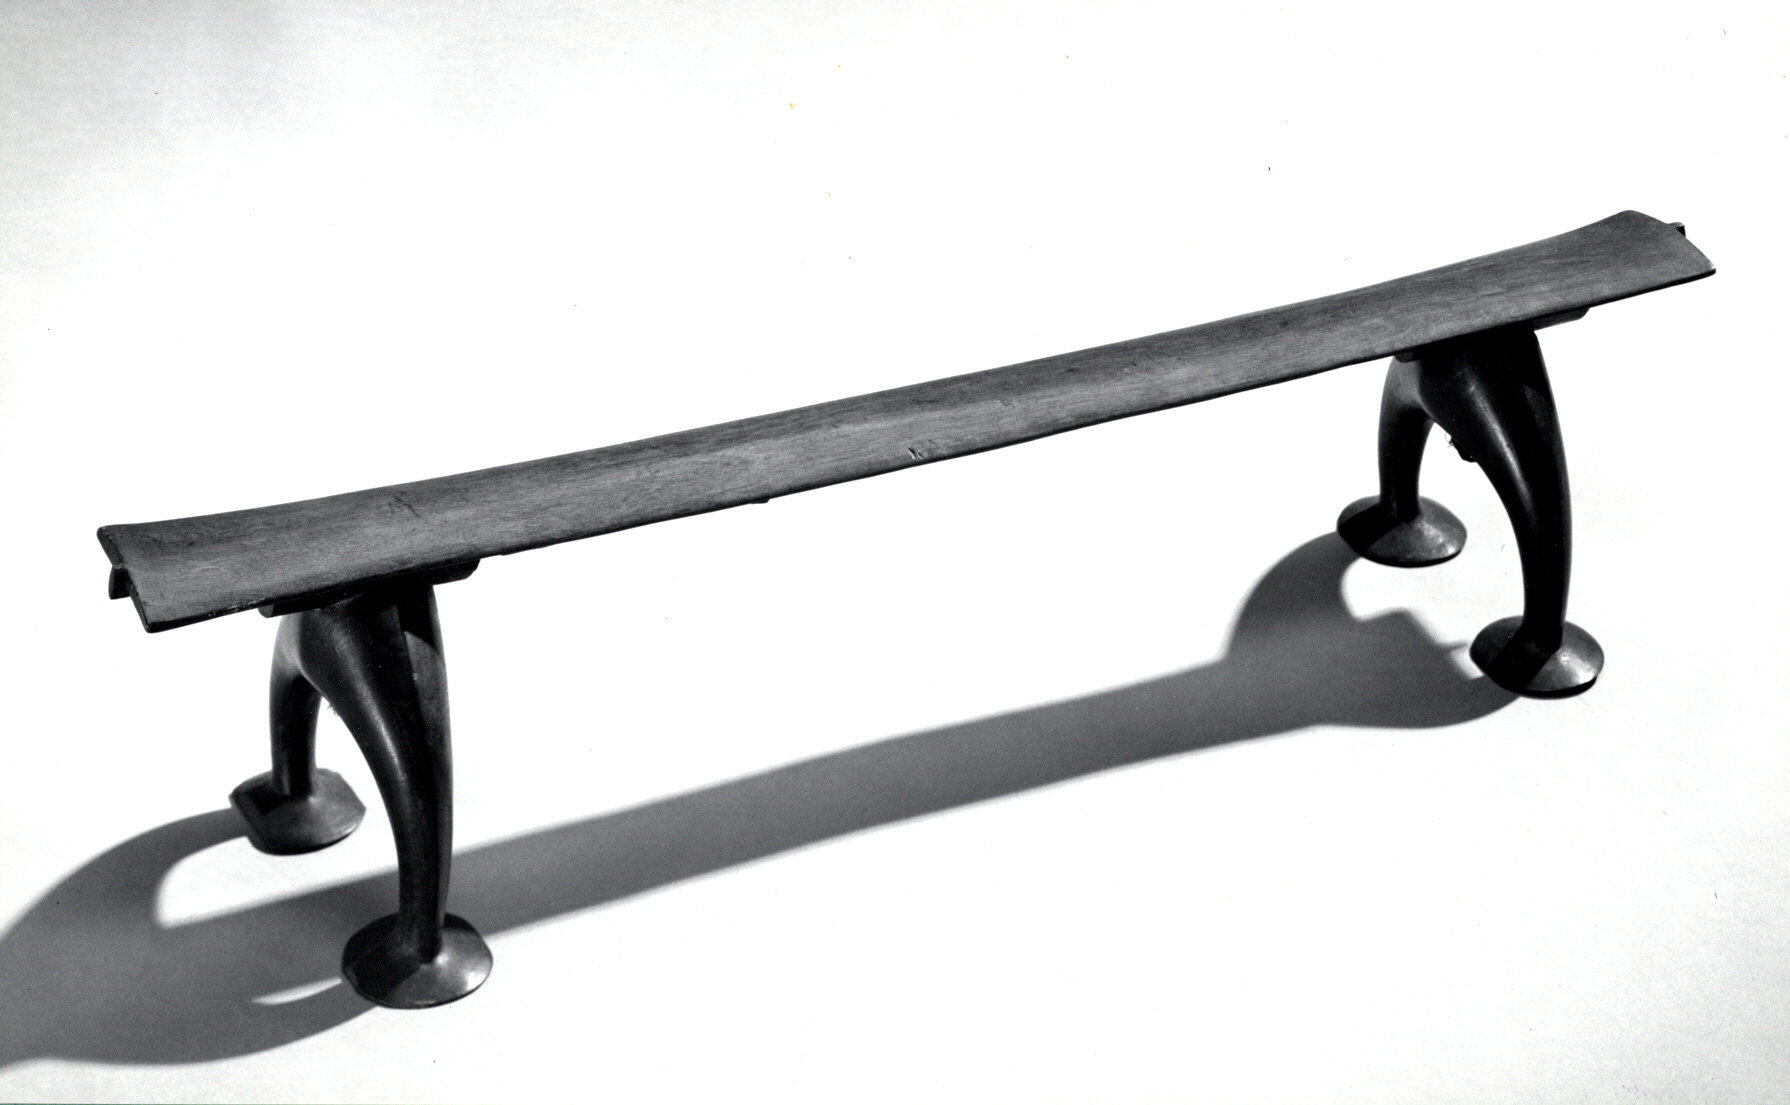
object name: headrest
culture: fijian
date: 1862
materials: fiber, wood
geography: fiji